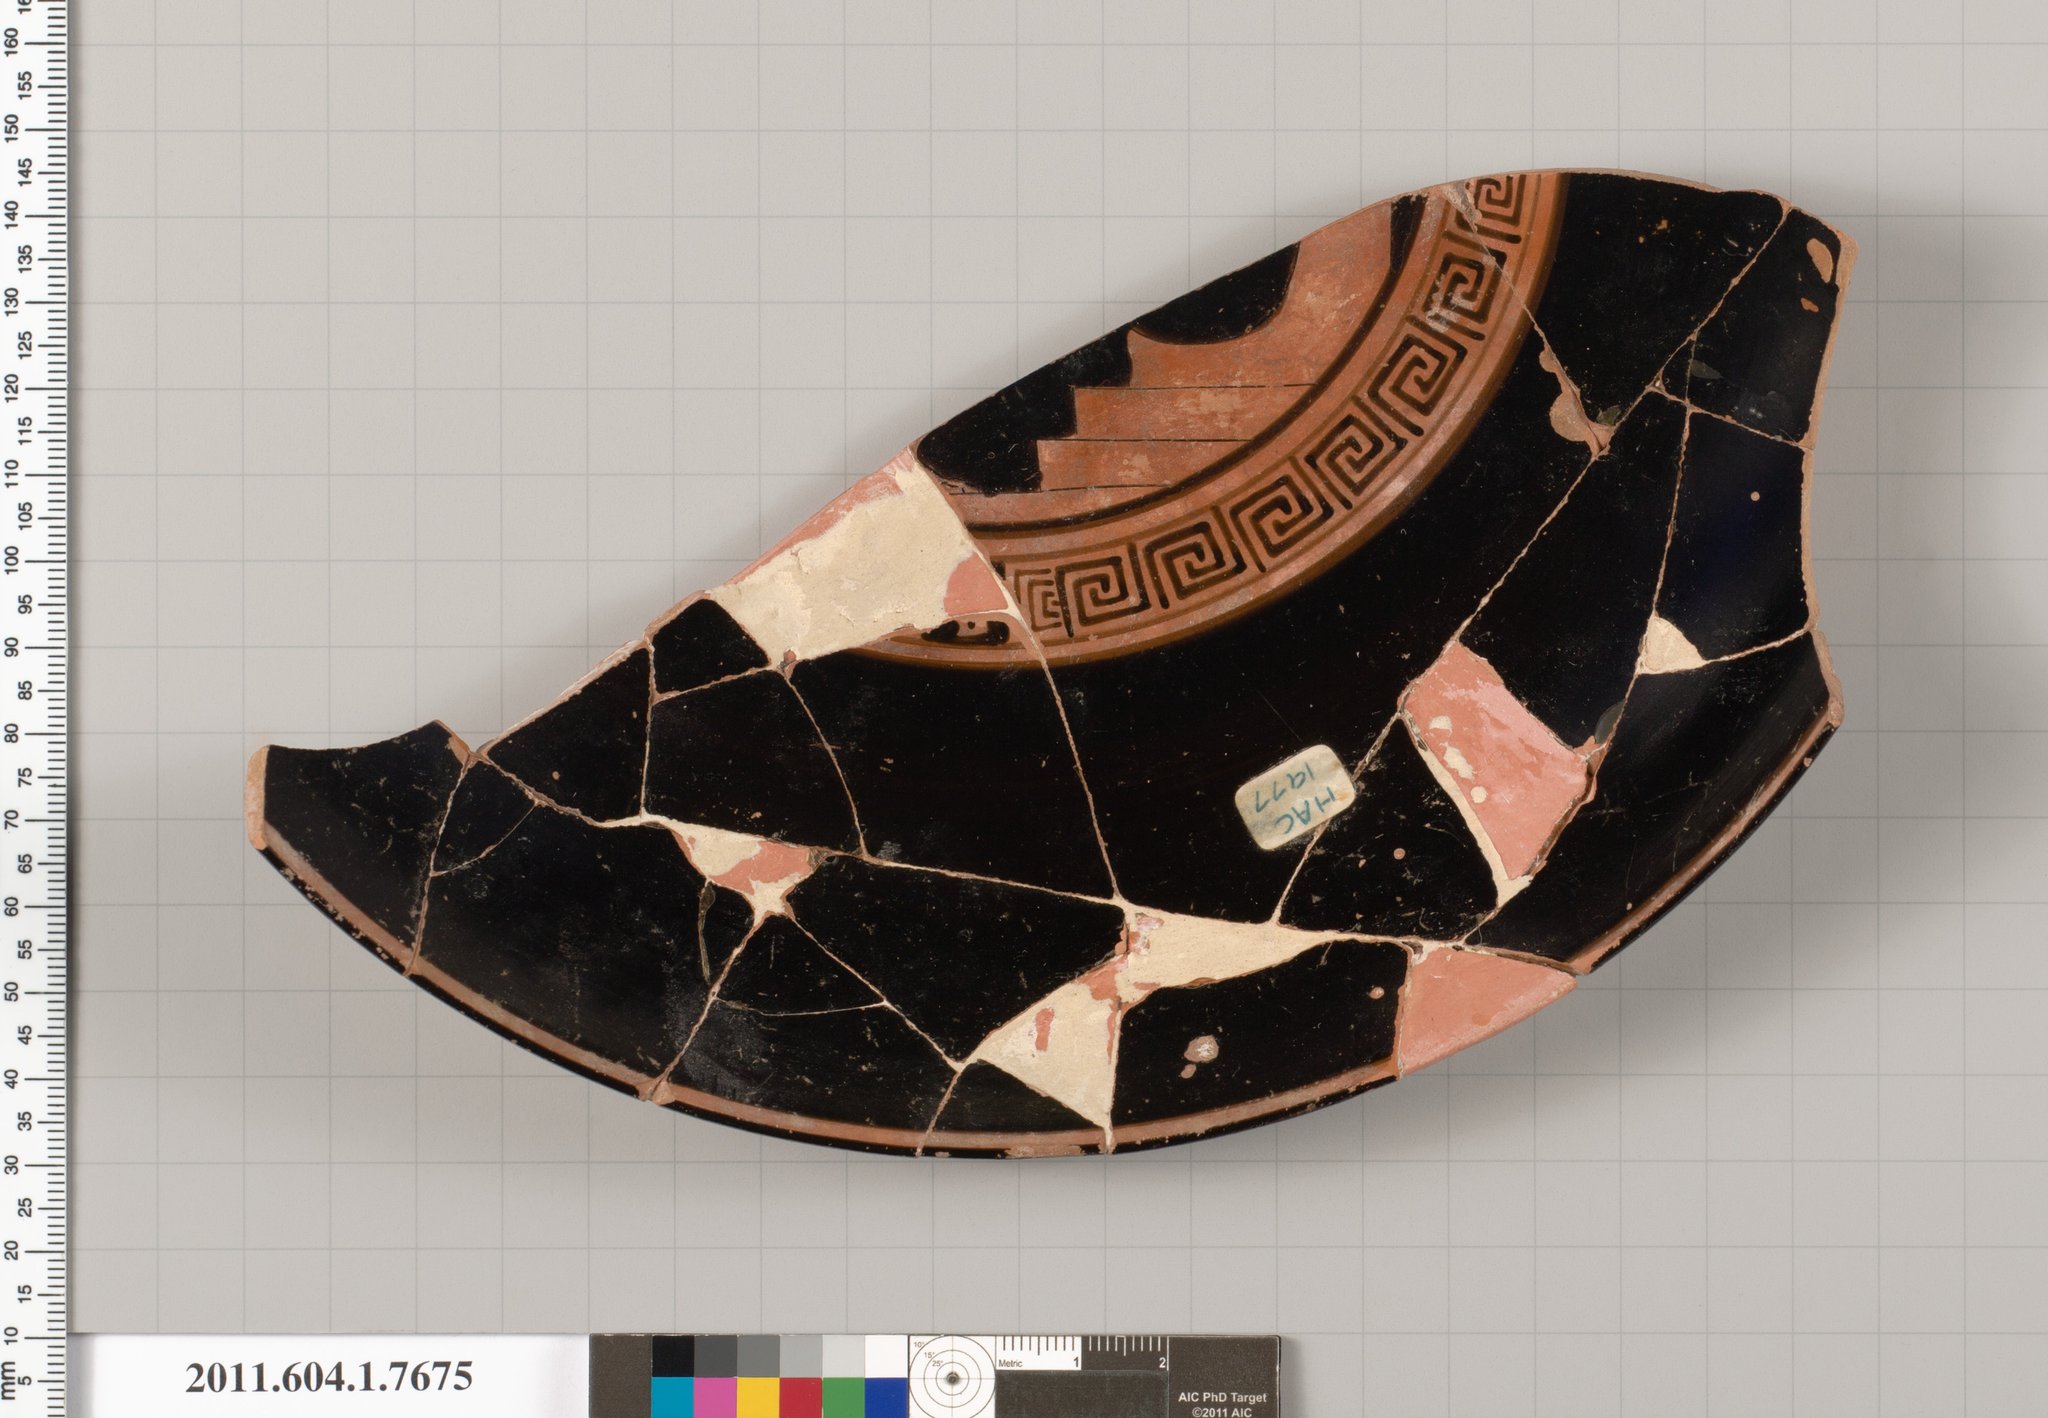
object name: kylix fragment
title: Terracotta rim fragment of a kylix (drinking cup)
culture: greek, attic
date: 475-451 BCE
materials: terracotta